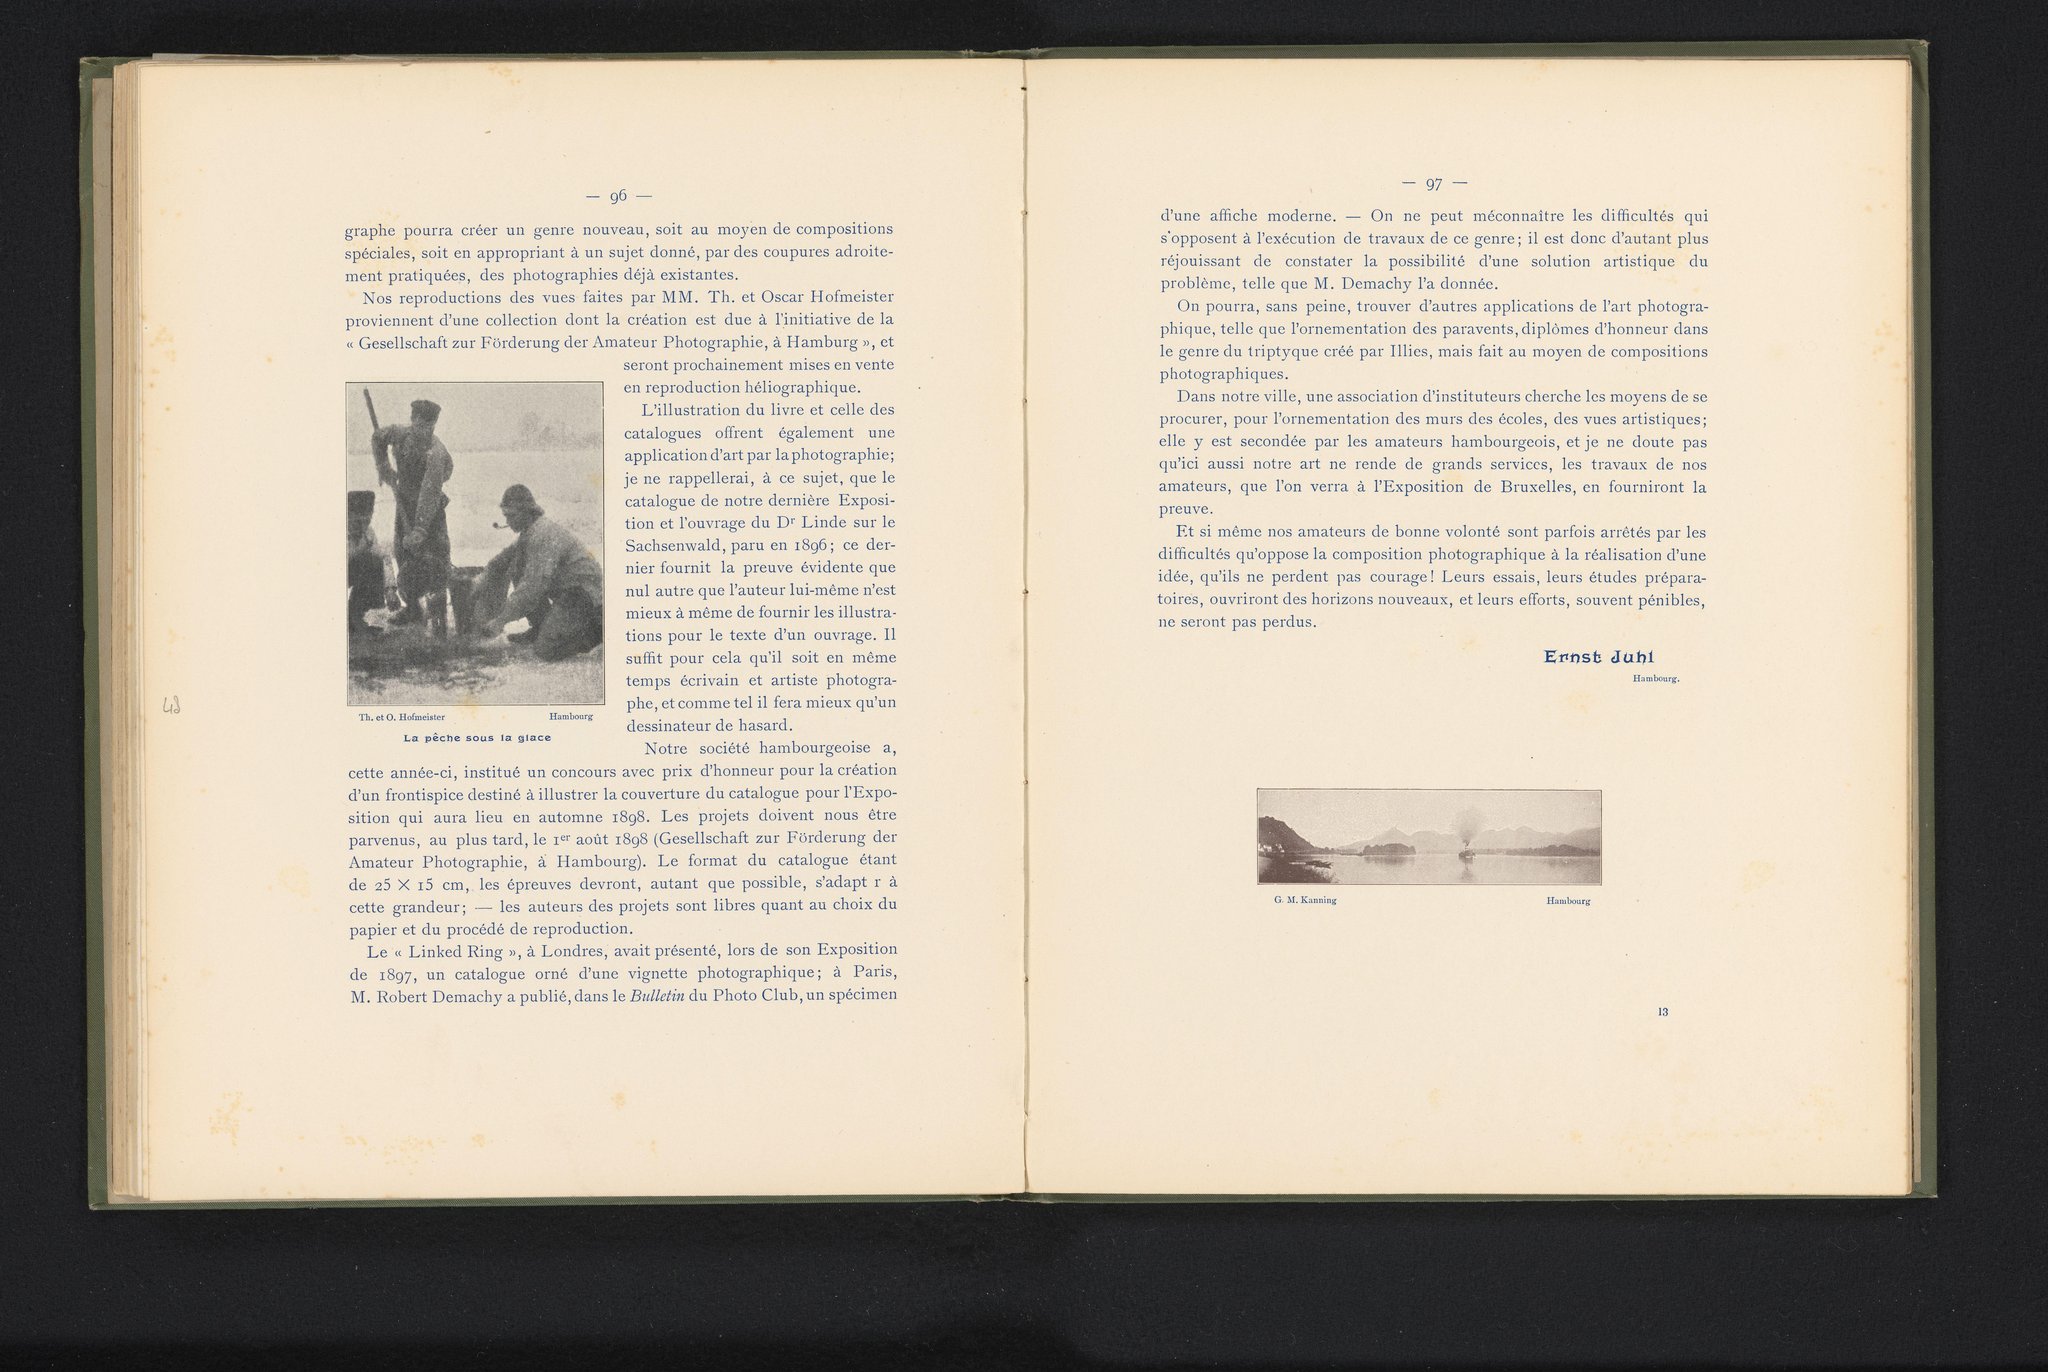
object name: photomechanical print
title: Drie onbekende mannen die ijsvissen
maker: th. u. o. hofmeister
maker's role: fotograaf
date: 1893-1898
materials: paper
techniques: autotype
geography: hamburg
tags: historical persons, ice ~ state of water, fisherman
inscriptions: inscription: ‘Hambourg’